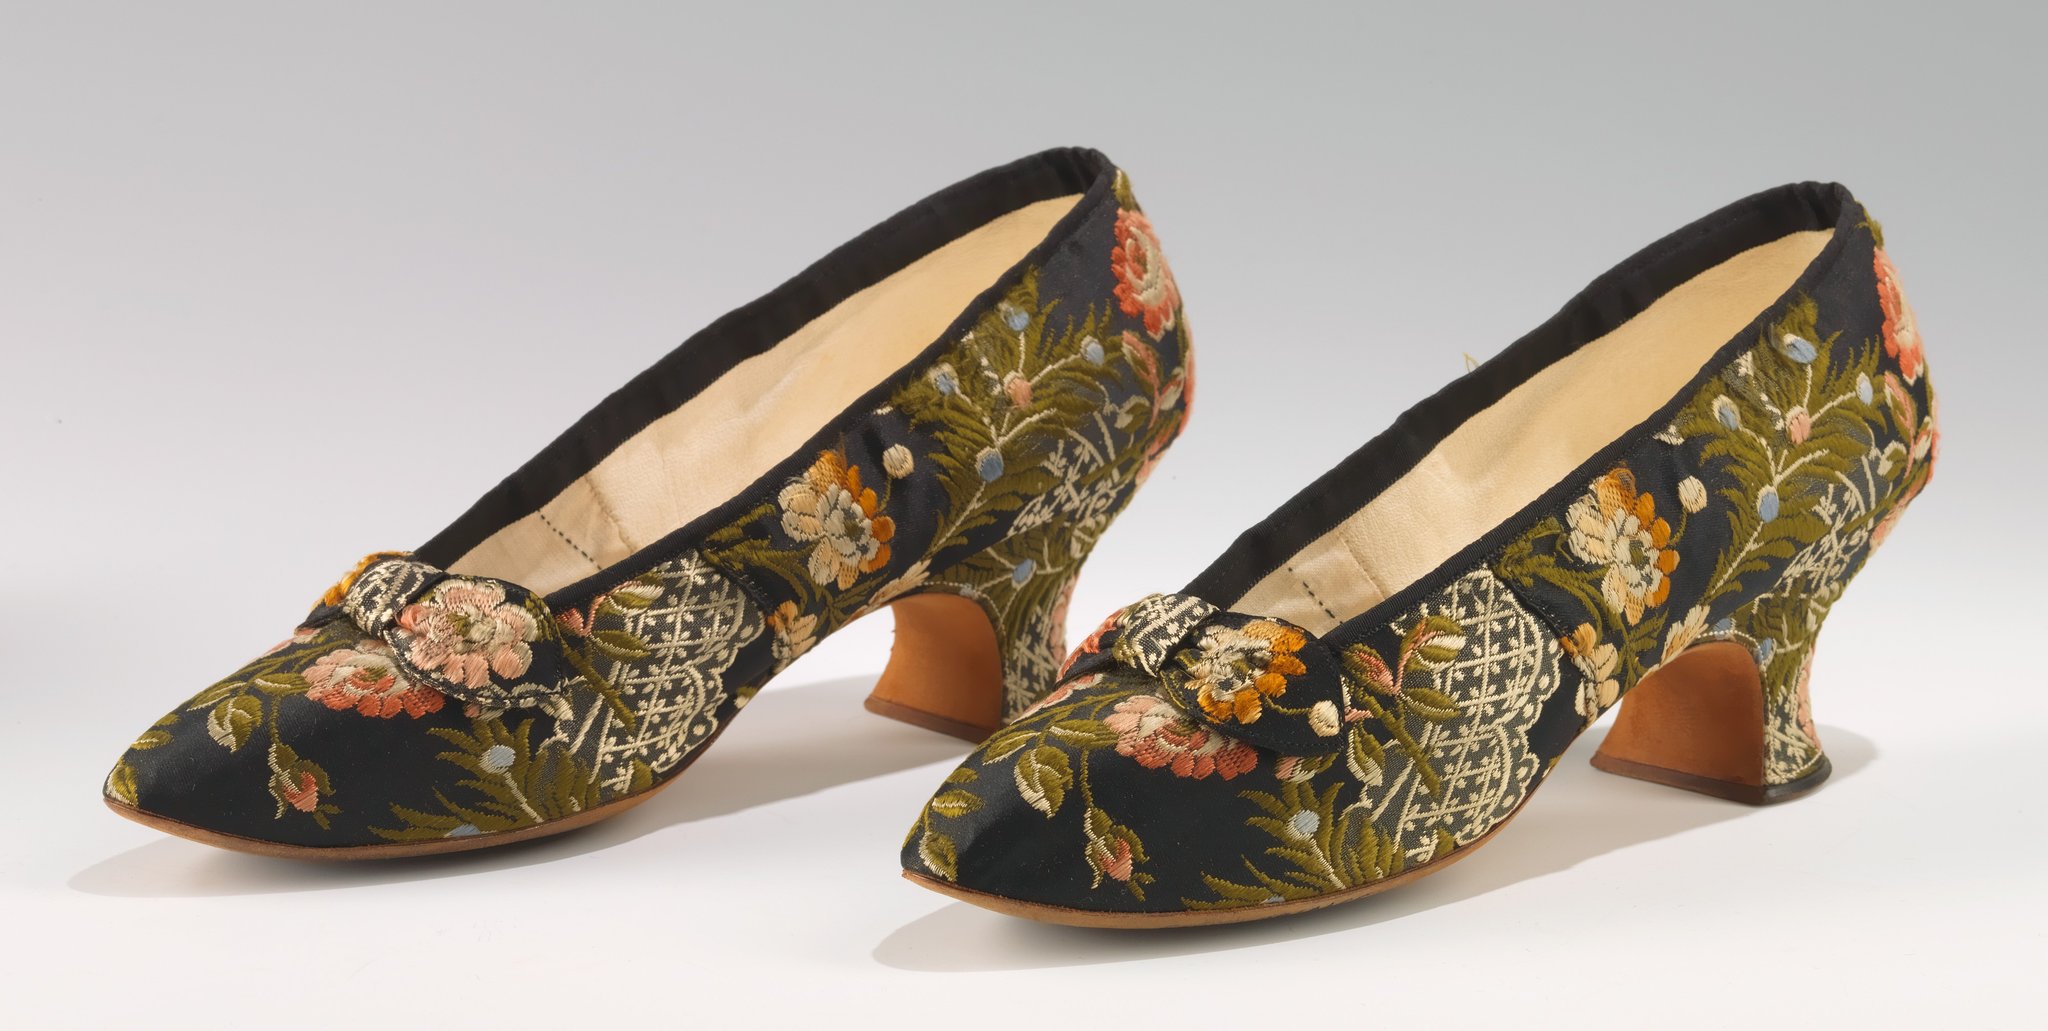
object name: evening slipper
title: Evening slippers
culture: french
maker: j. ferry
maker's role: designer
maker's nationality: french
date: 1880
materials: silk